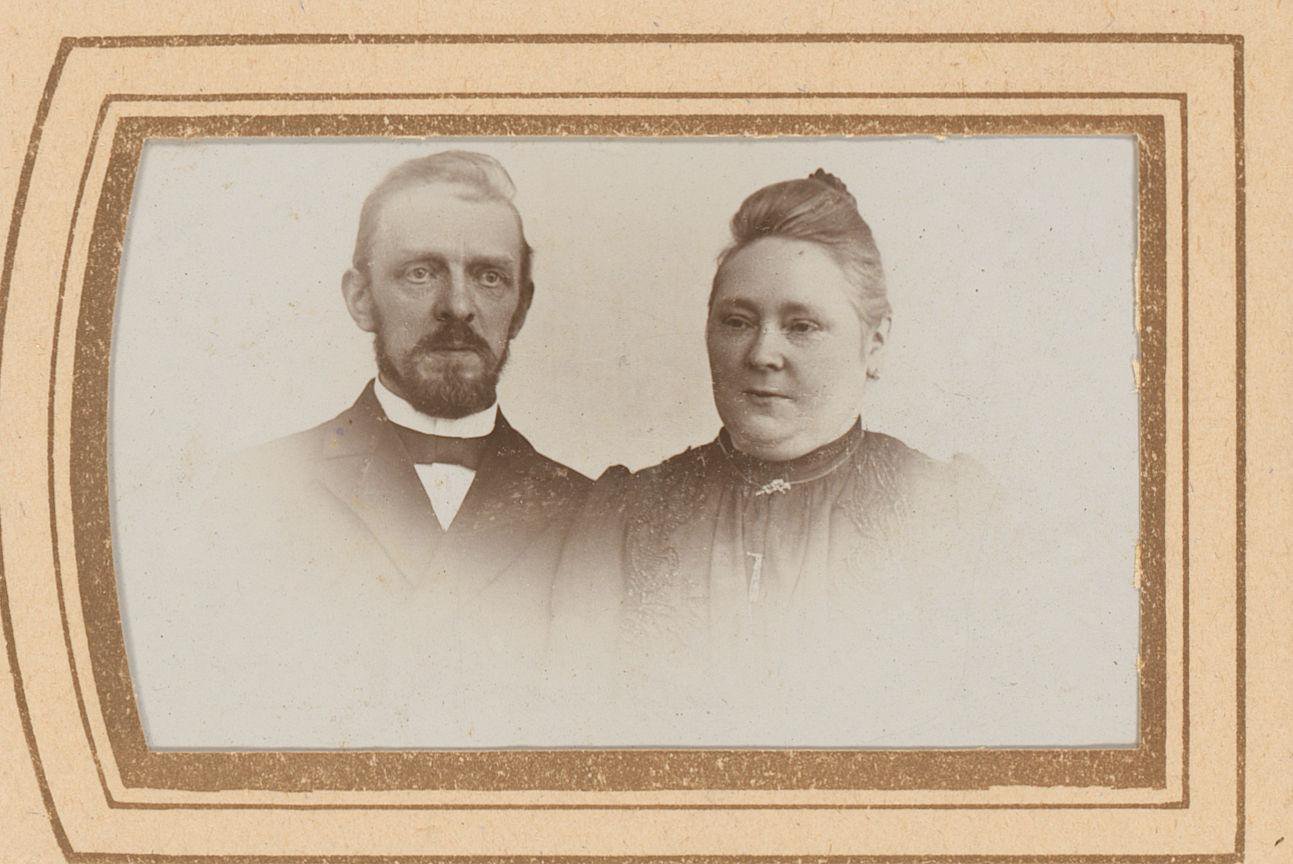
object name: album leaf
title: Portret van een man en vrouw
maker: Anonymous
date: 1880-1920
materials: cardboard, photographic support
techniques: collodion silver print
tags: adult woman, adult man, historical persons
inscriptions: inscription: ‘Studio Hoogewoerd 165/ Leiden’